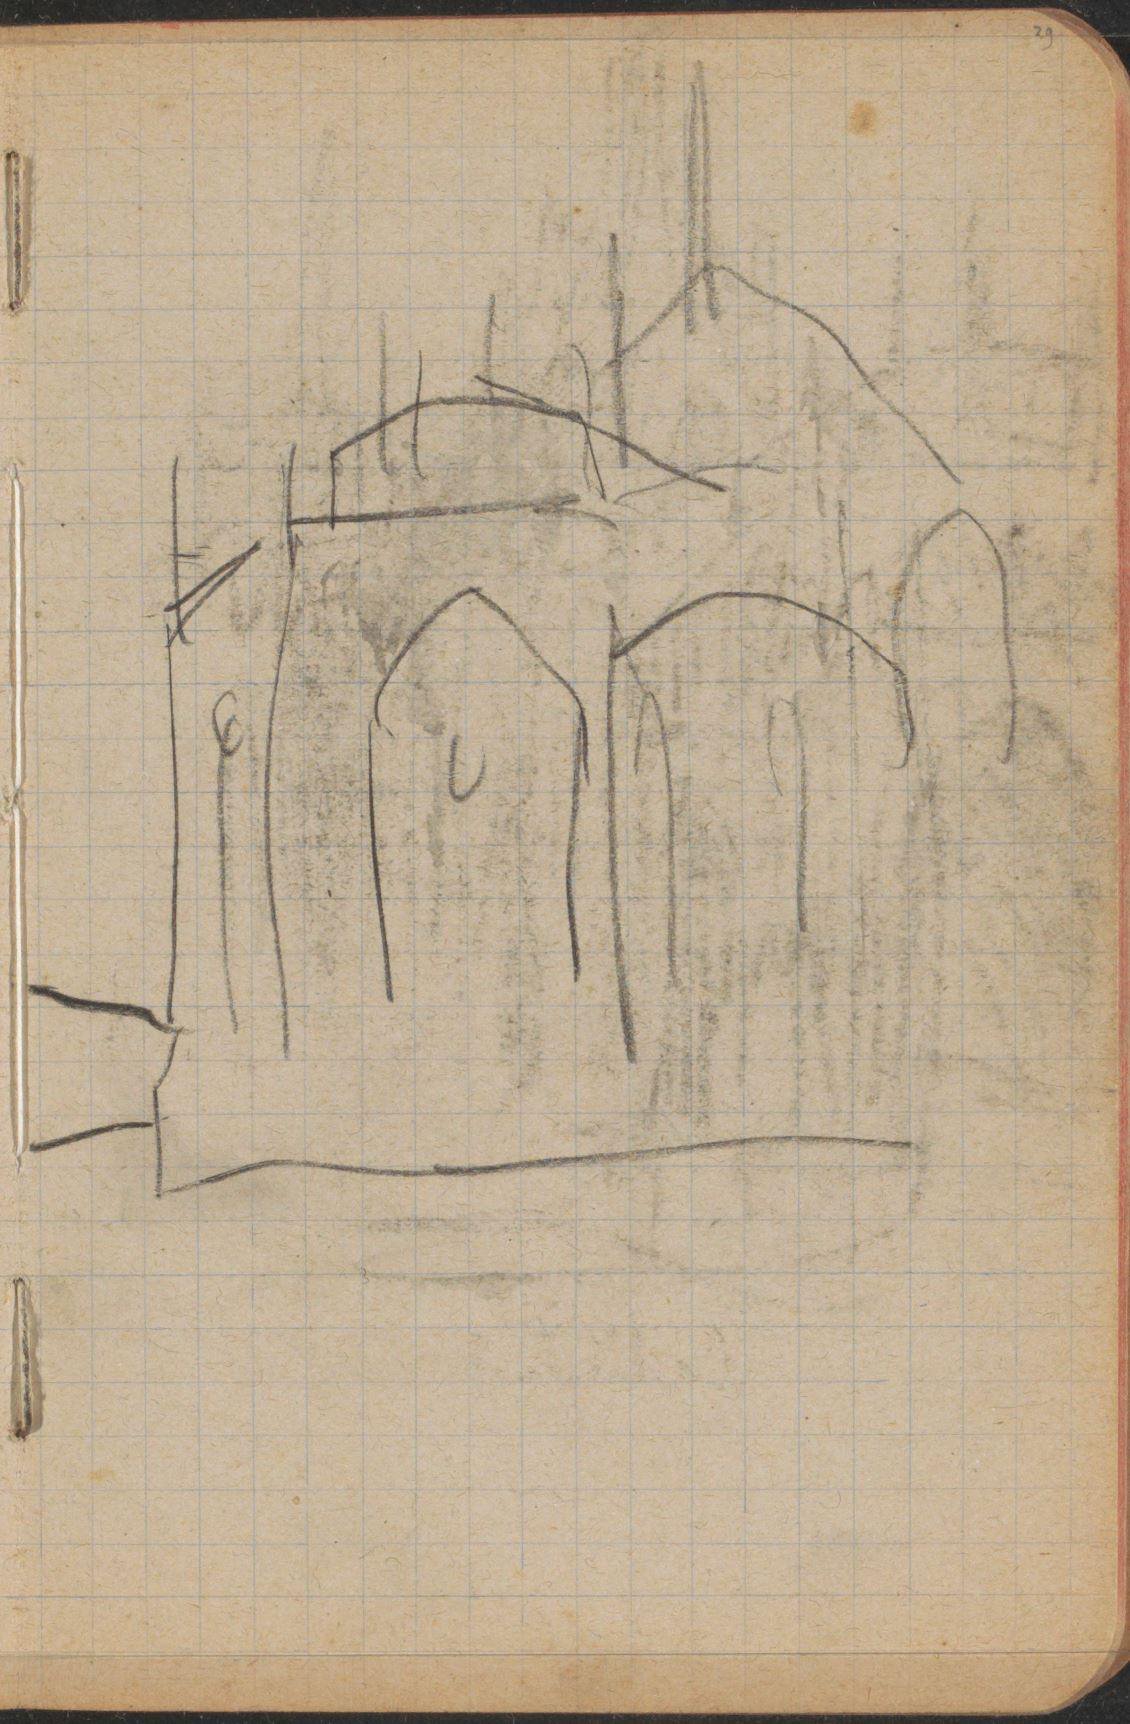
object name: sketchbook leaf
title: Architectuurstudie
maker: marius bauer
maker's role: draughtsman, print maker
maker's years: 1867-1932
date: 1895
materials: chalk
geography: milan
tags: church (exterior), roman catholic church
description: Mogelijk de Dom van Milaan. Pagina 29 uit een schetsboek met 28 bladen.